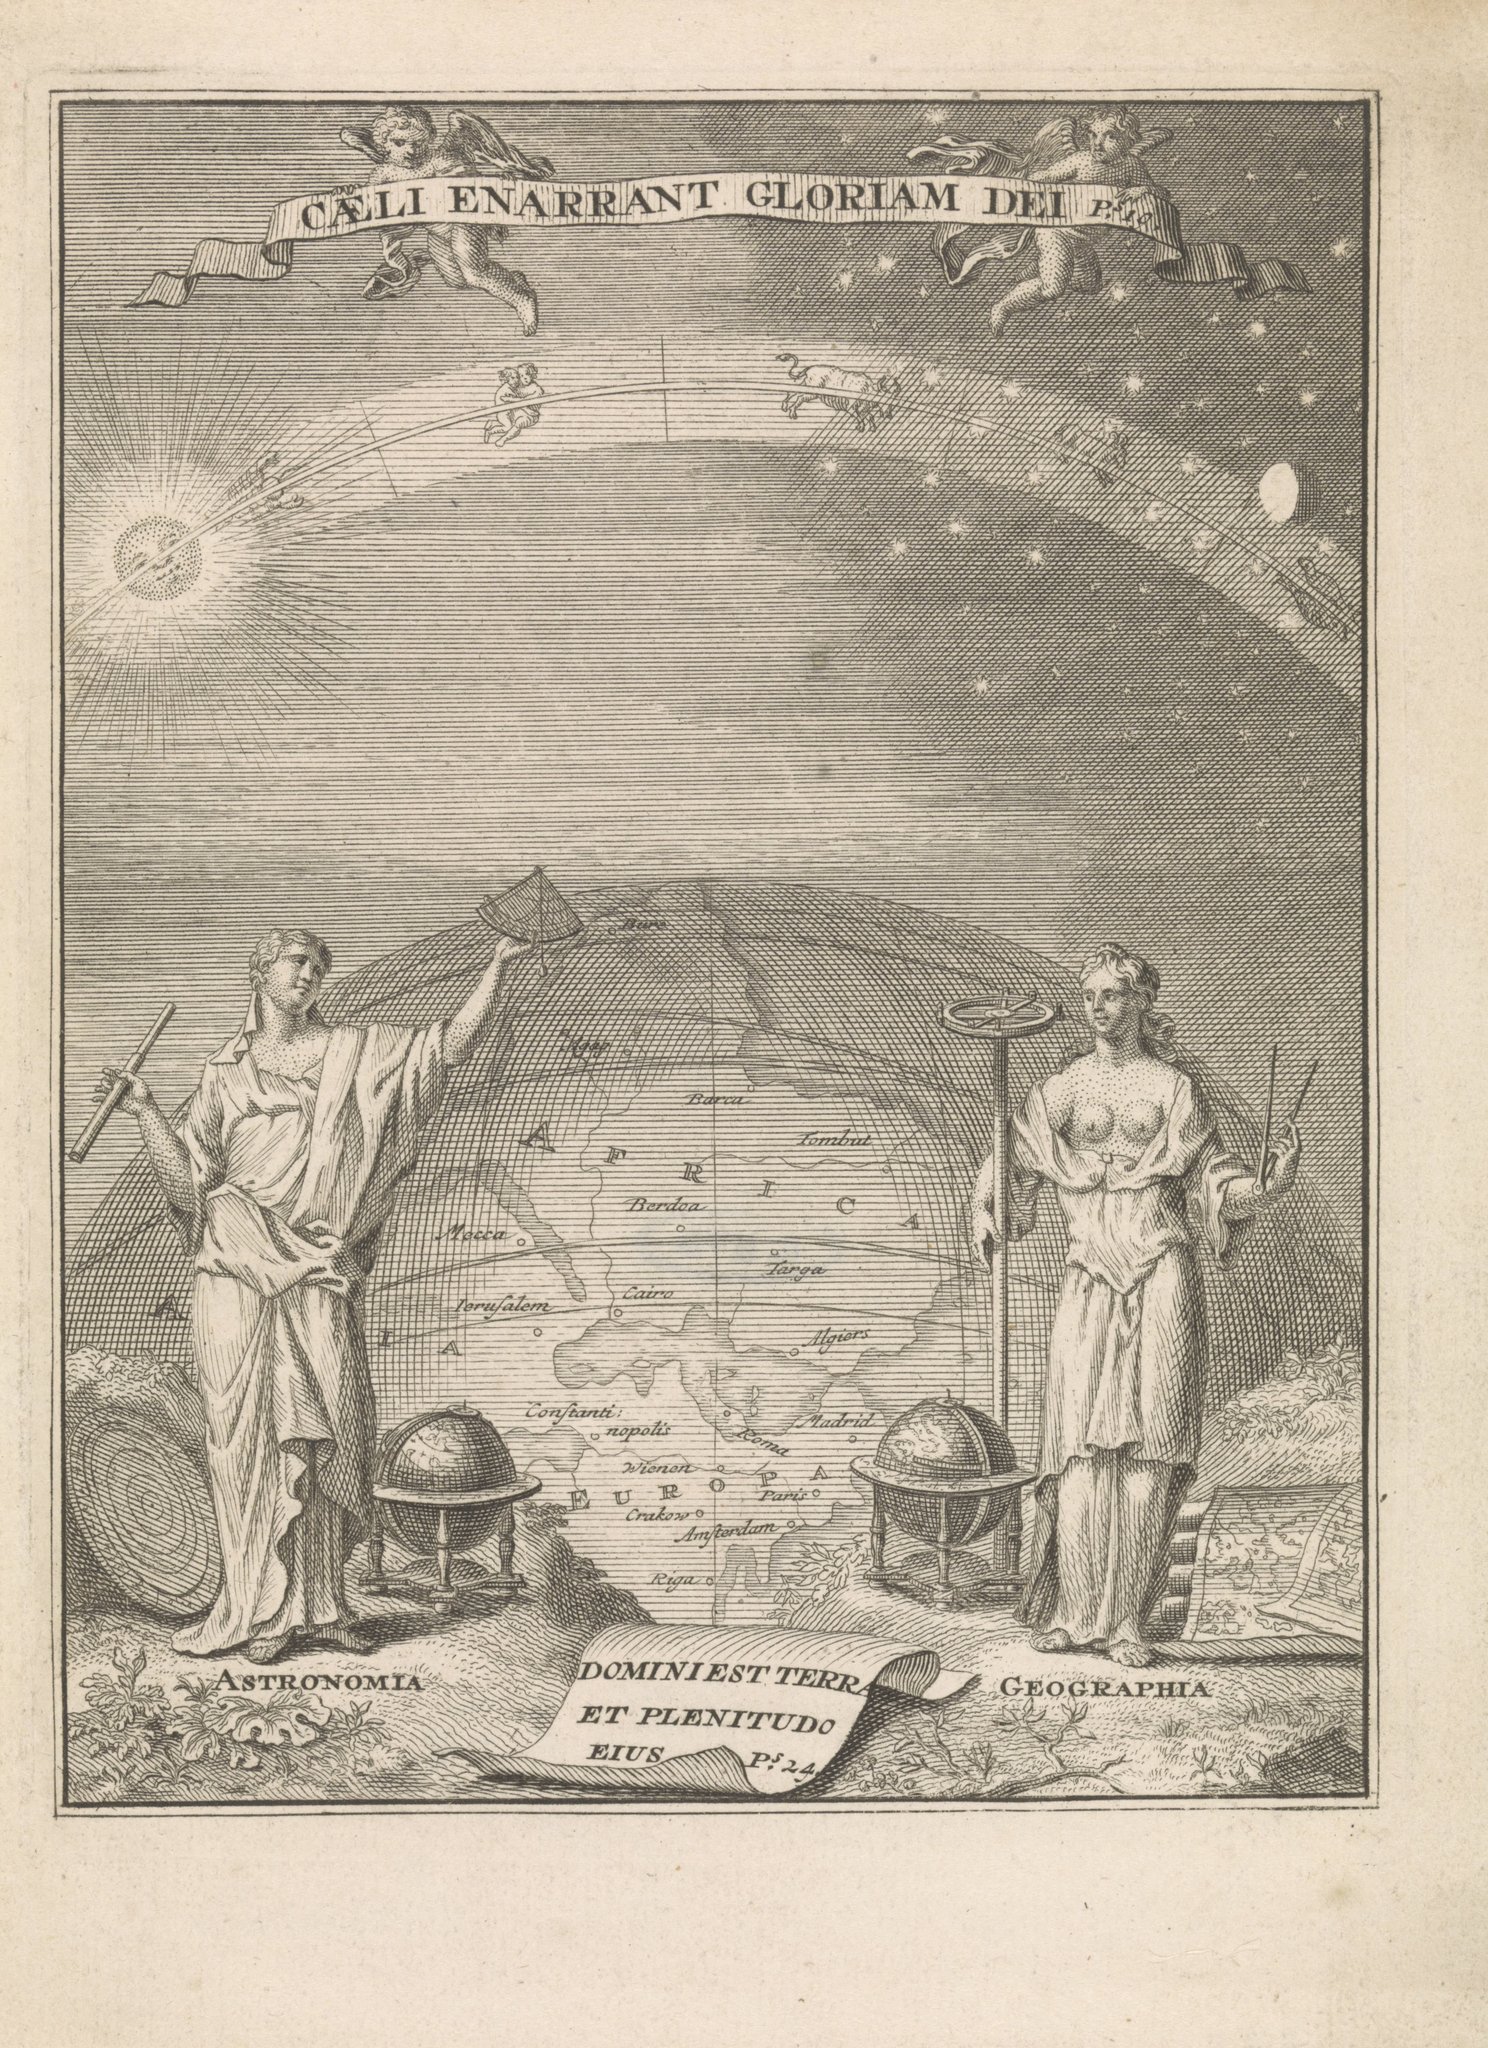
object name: titelblad, titelpagina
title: Titelpagina voor: 't Werkstellige der sterre-konst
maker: leonardus valck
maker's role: print maker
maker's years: 1675-1755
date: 1706-1730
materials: paper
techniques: engraving, etching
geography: amsterdam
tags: 'geografia', maps, atlases, measuring-instruments, globe, the heavens (celestial bodies), star-chart, star map, star-globe, astronomy (and cosmography)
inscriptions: collector's mark: Lugt 2228, collector's mark: Lugt 2760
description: De vrouwelijke personificaties van Astronomie (Astronomia) en Geografie (Geographia), met meetinstrumenten in hun handen, onder een sterrenhemel met op de achtergrond de aarde. In de lucht twee engelen met een banderol en de zon, de maan en enkele tekenen van de dierenriem. Naast Astronomia een hemelglobe en een kaart met de banen van de planeten en naast Geogrphia een aardglobe en landkaarten.